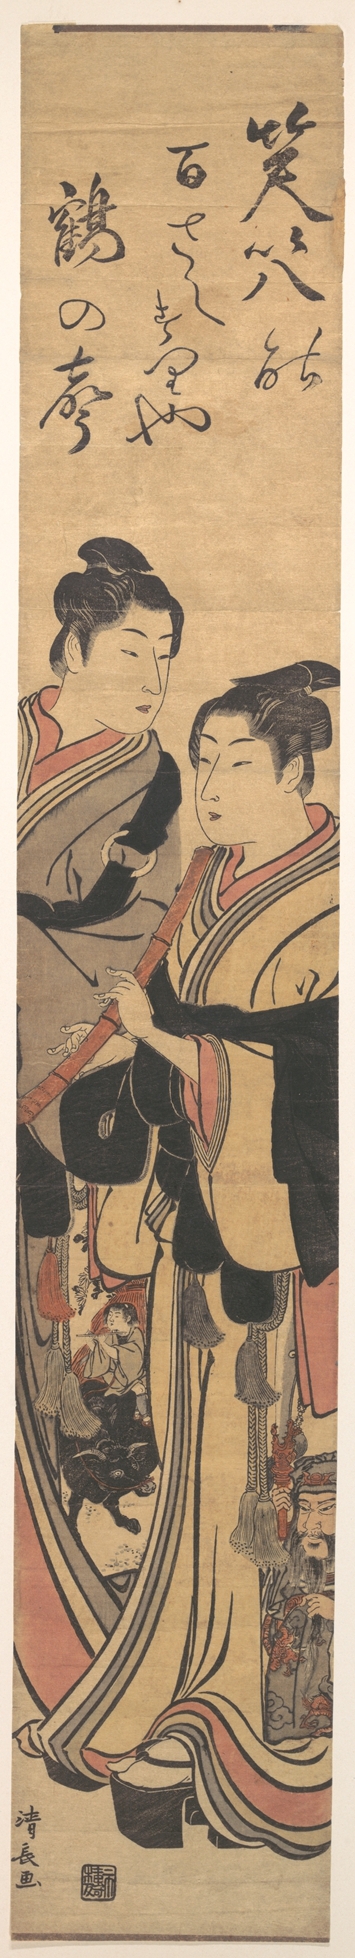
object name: print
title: Two Men, One Playing a Flute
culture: japanese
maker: torii kiyonaga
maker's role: artist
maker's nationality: japanese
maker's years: 1752-1815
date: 1742-1815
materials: ink, paper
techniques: woodblock print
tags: men,music,flutes